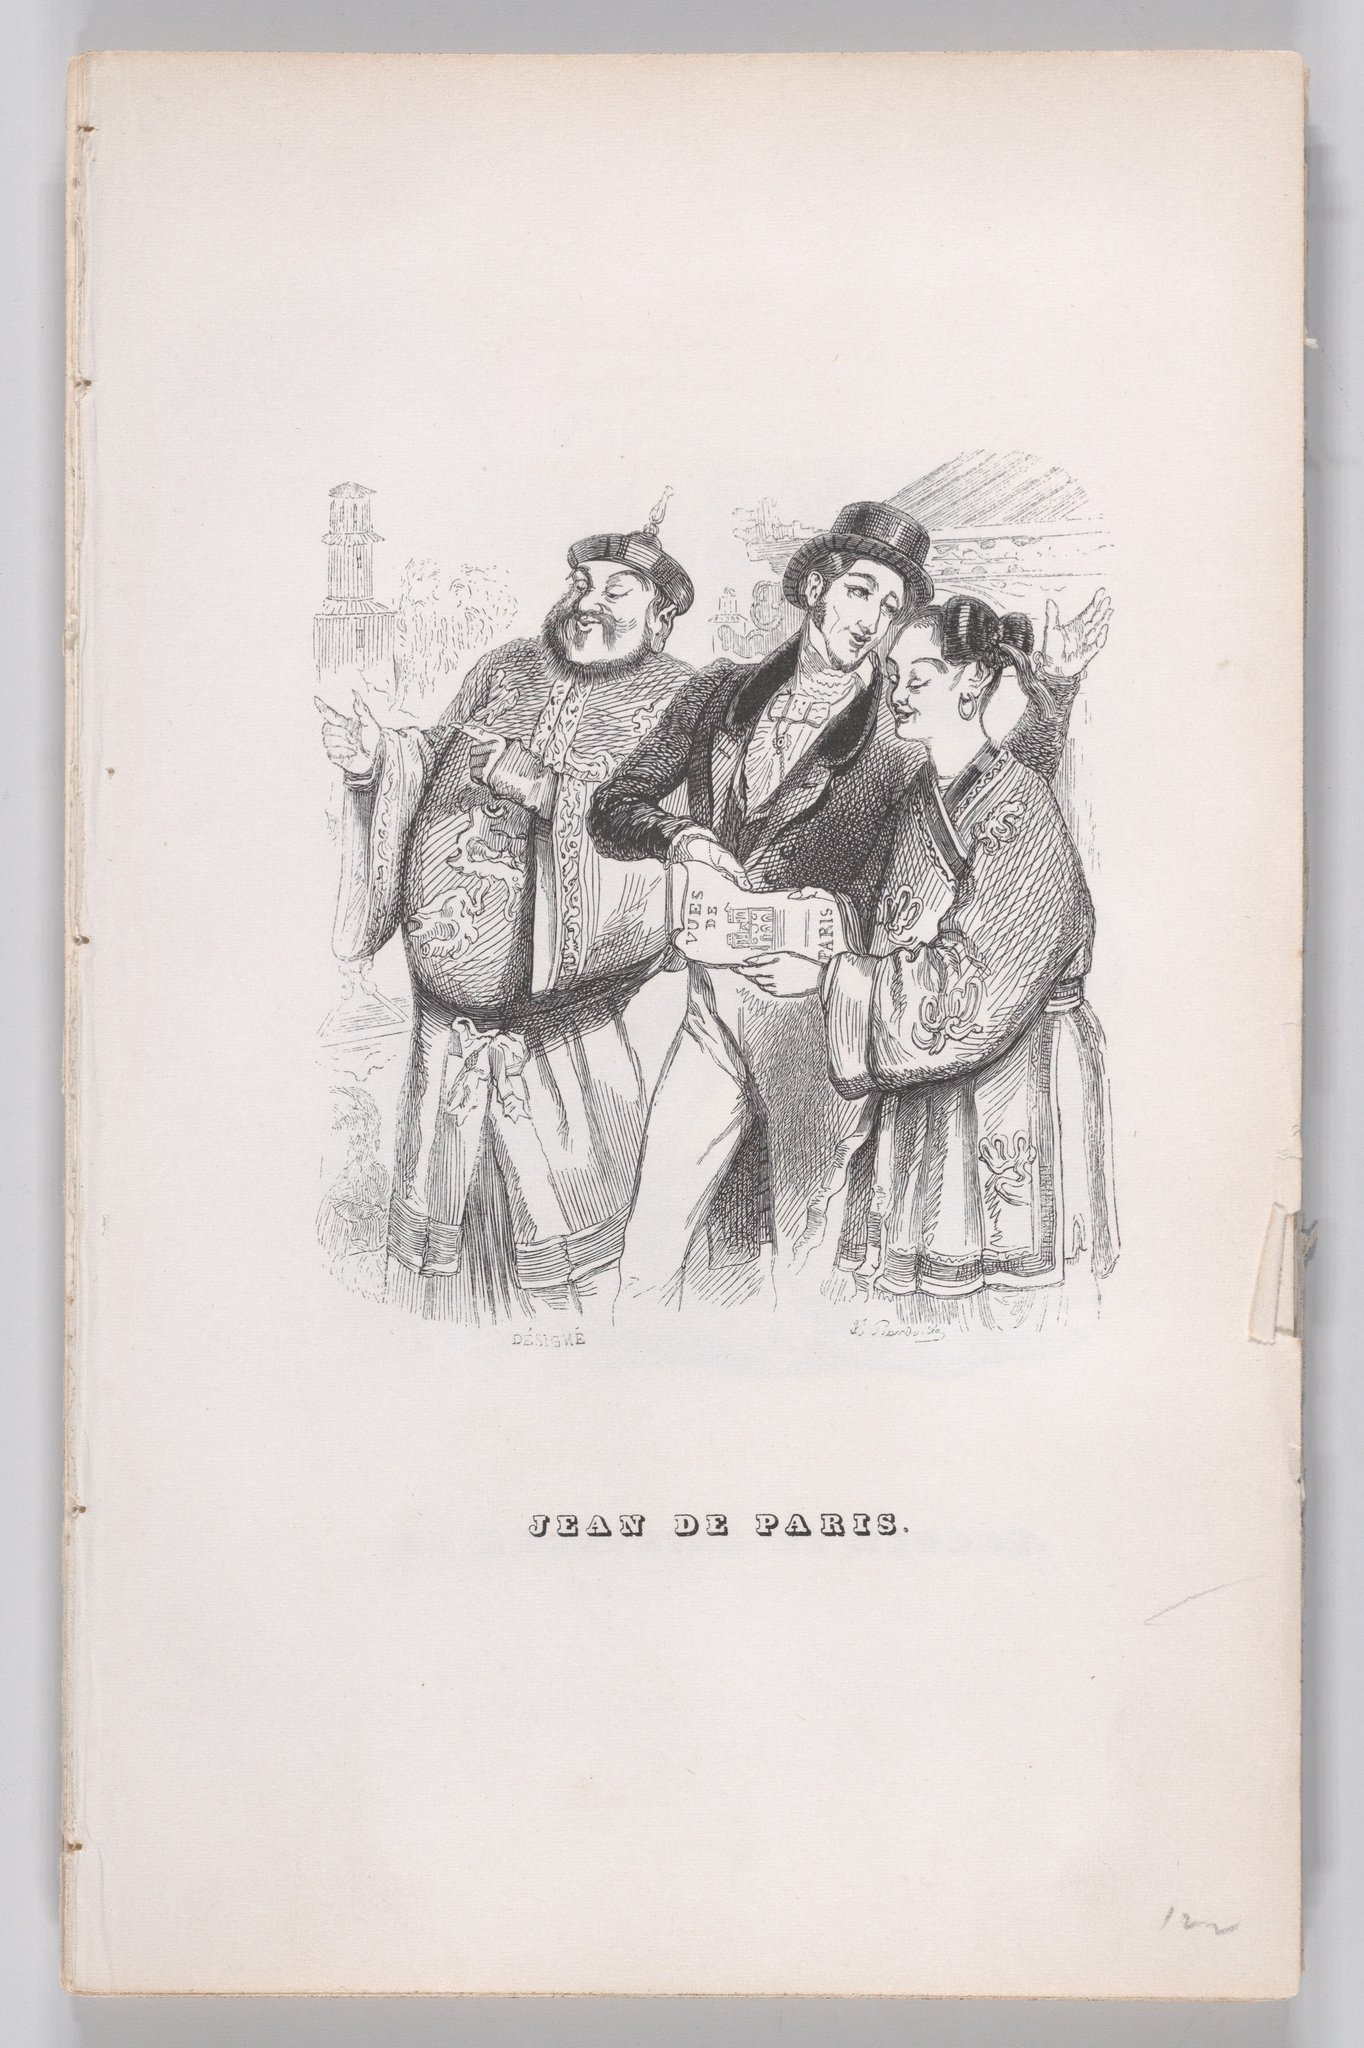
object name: print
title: Jean of Paris, from "The Complete Works of Béranger"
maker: j. j. grandville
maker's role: illustrator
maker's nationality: french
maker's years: 1803-1847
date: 1836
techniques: engraving